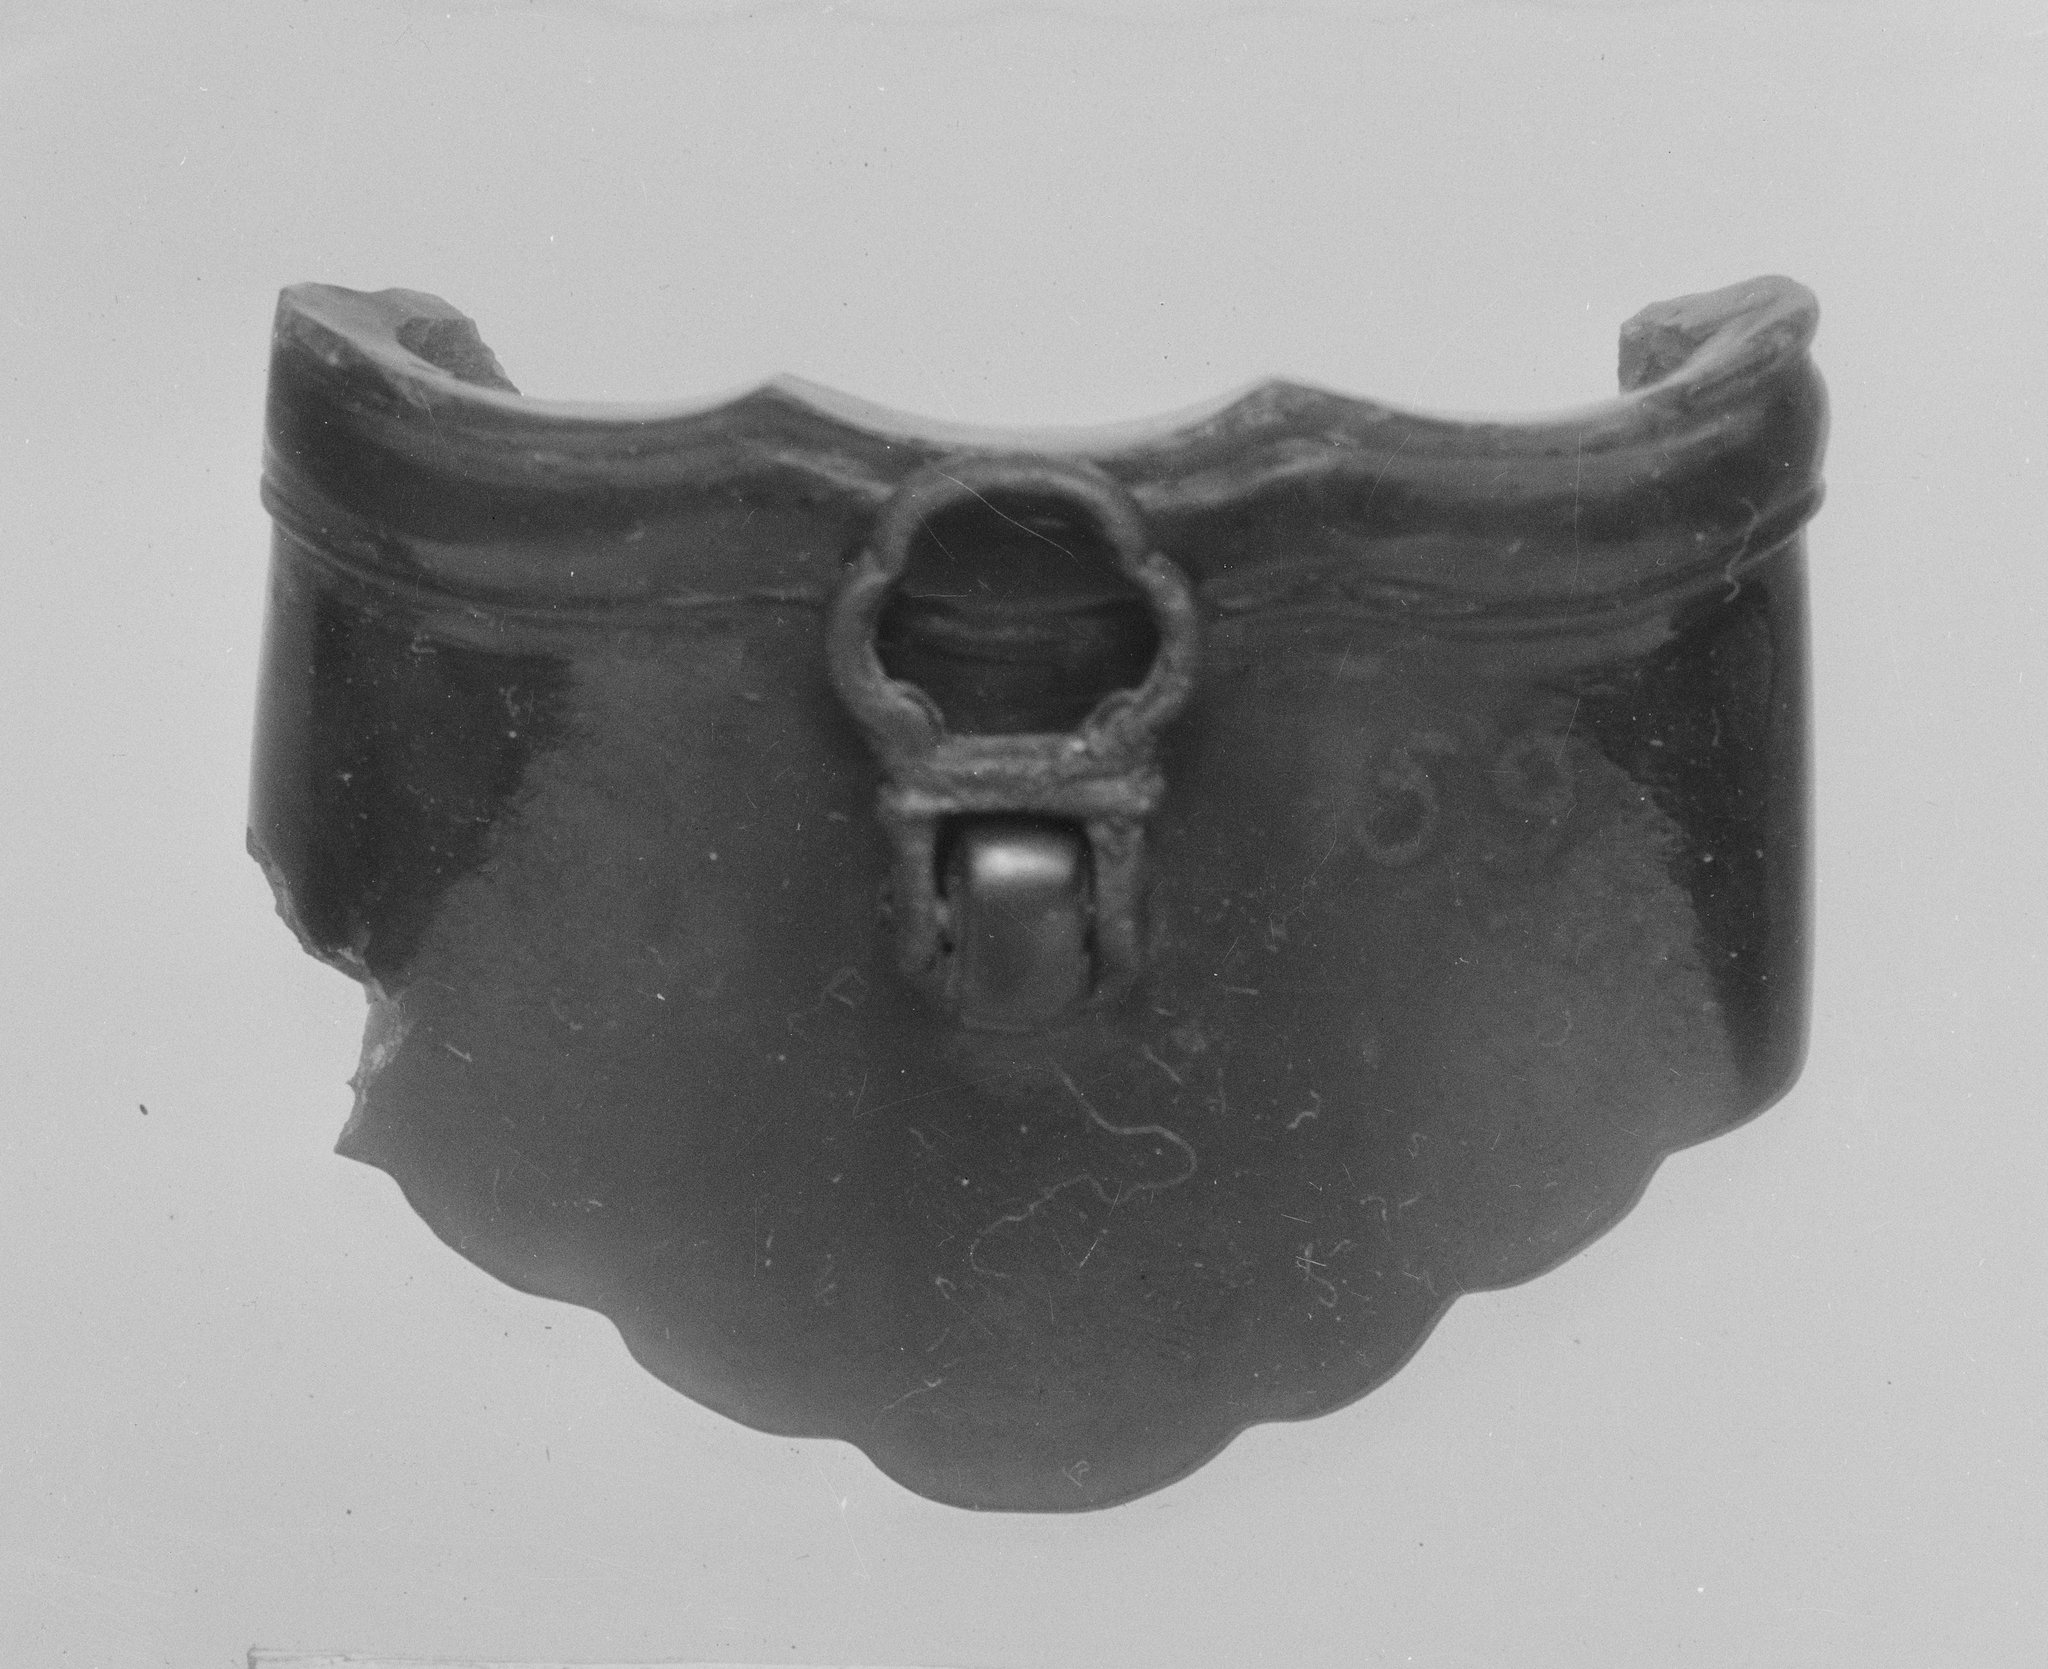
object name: sword with scabbard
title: Top of a Sword Scabbard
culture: indian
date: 1601-1900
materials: jade